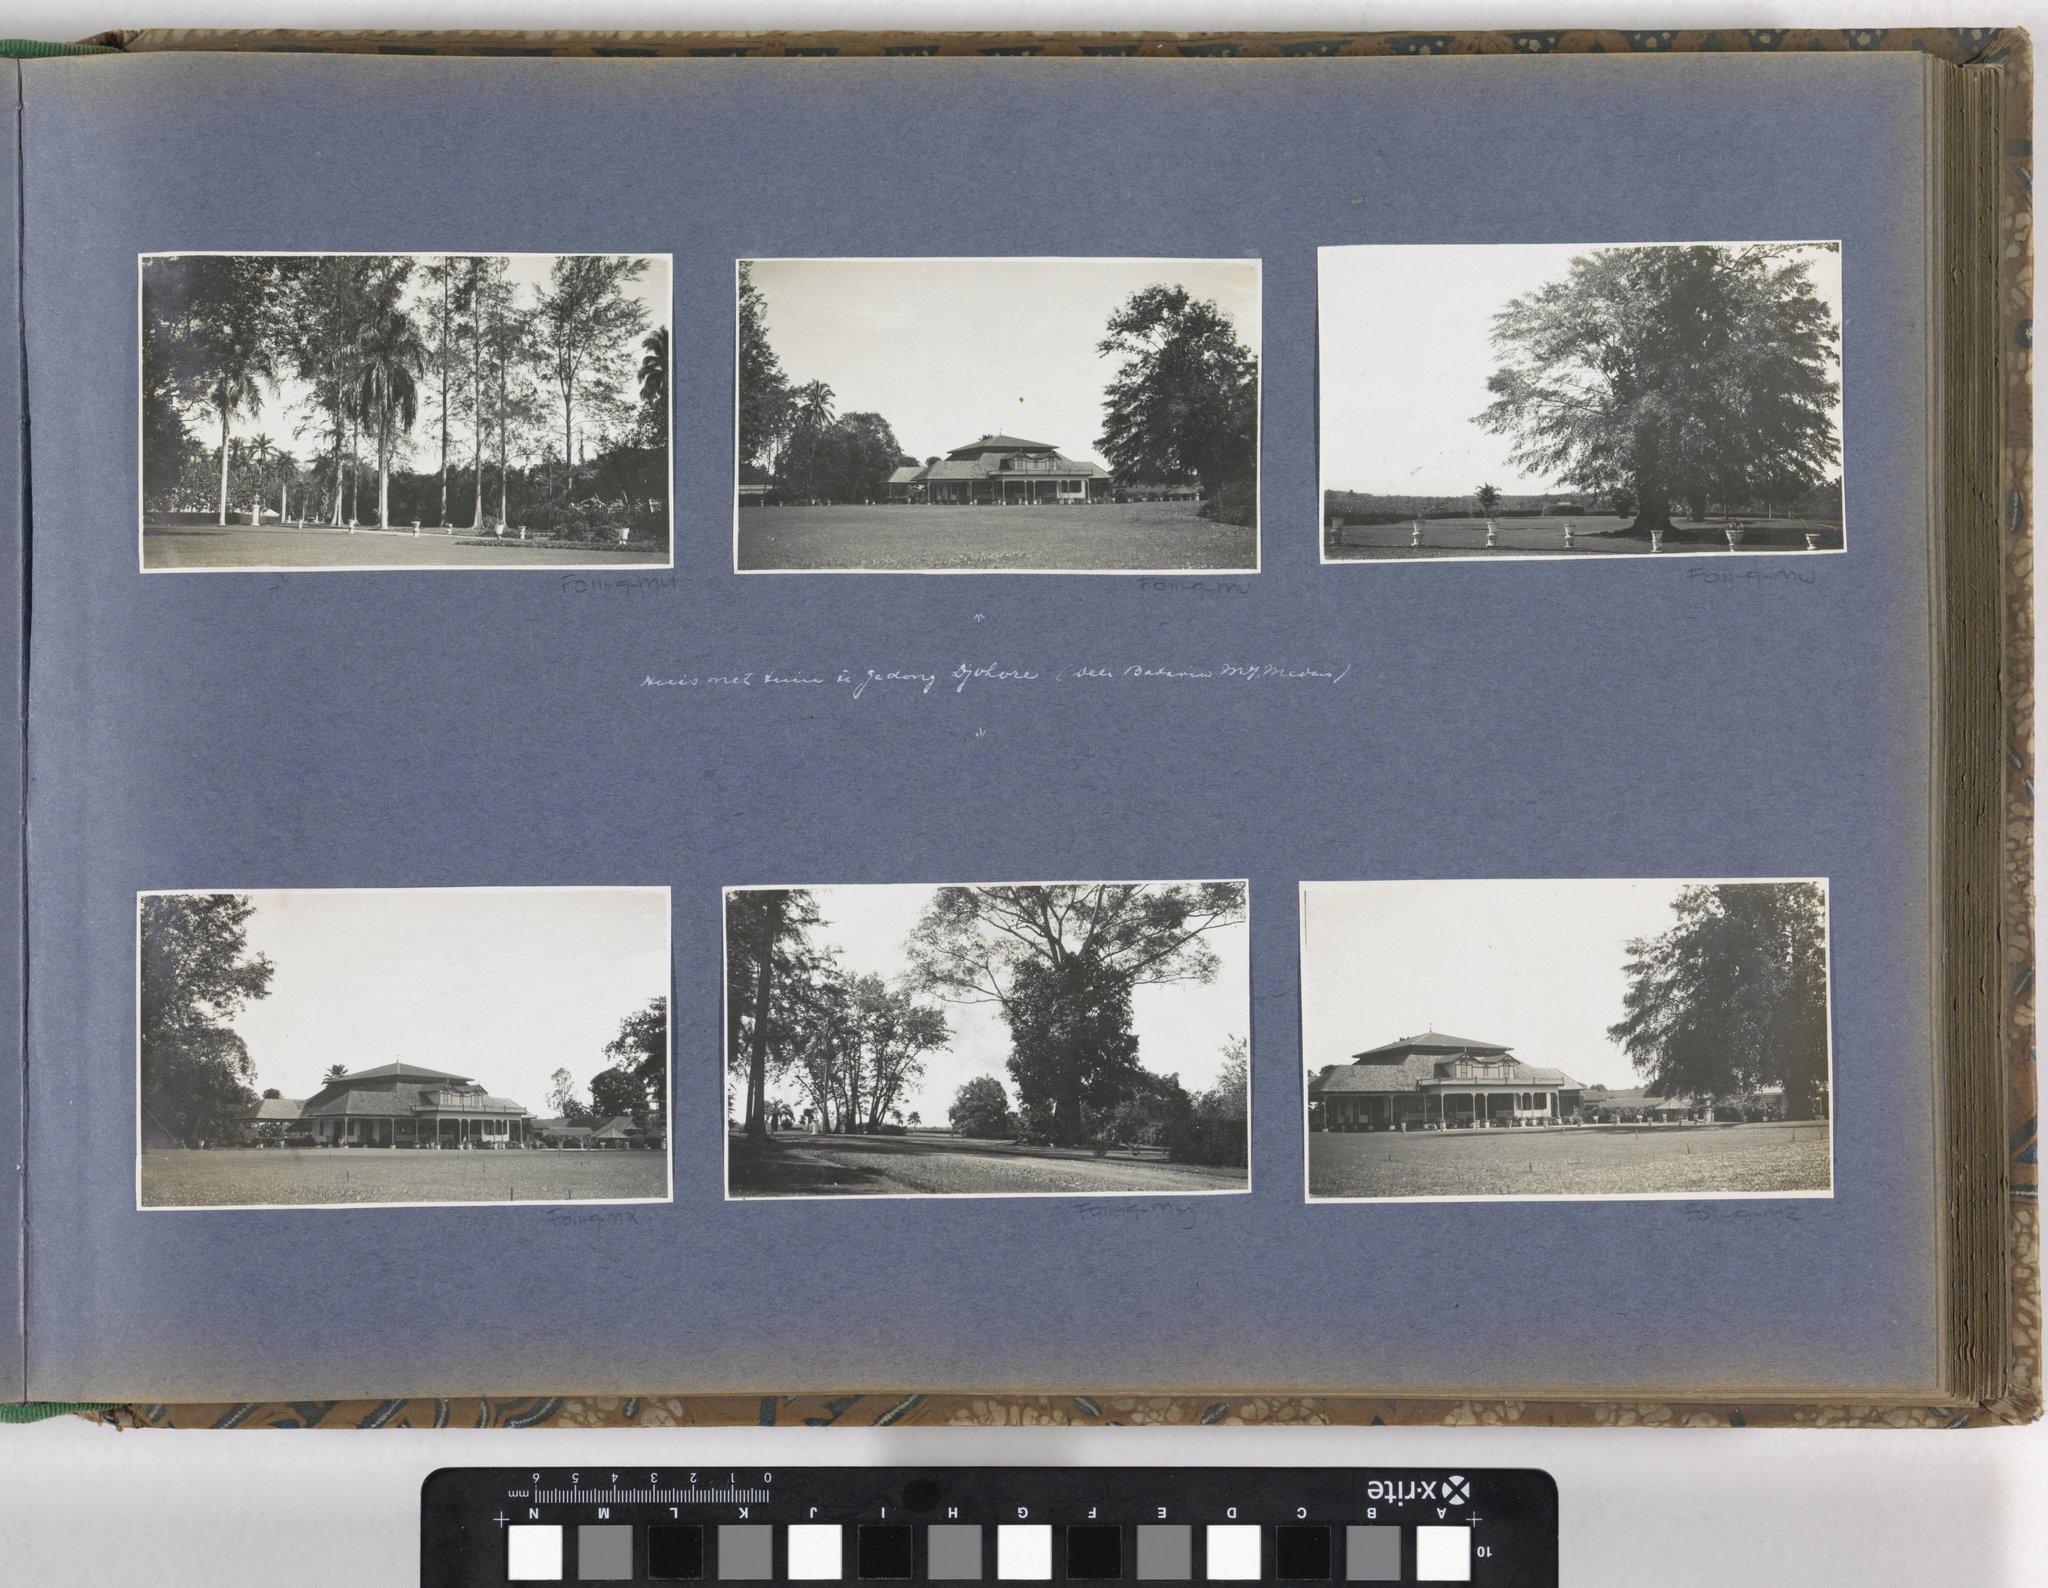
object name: album leaf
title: Tuin van cultuuronderneming Gedong Djohore van de Deli-Batavia Maatschappij bij Medan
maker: Anonymous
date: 1900-1920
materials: paper, photographic support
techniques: gelatin silver print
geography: sumatra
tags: plantation, trees, garden, sumatra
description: Onderdeel van reisalbum met foto's van bedrijvigheid en bezienswaardigheden op Sumatra en Java en van de reis naar en van Nederlands-Indië.